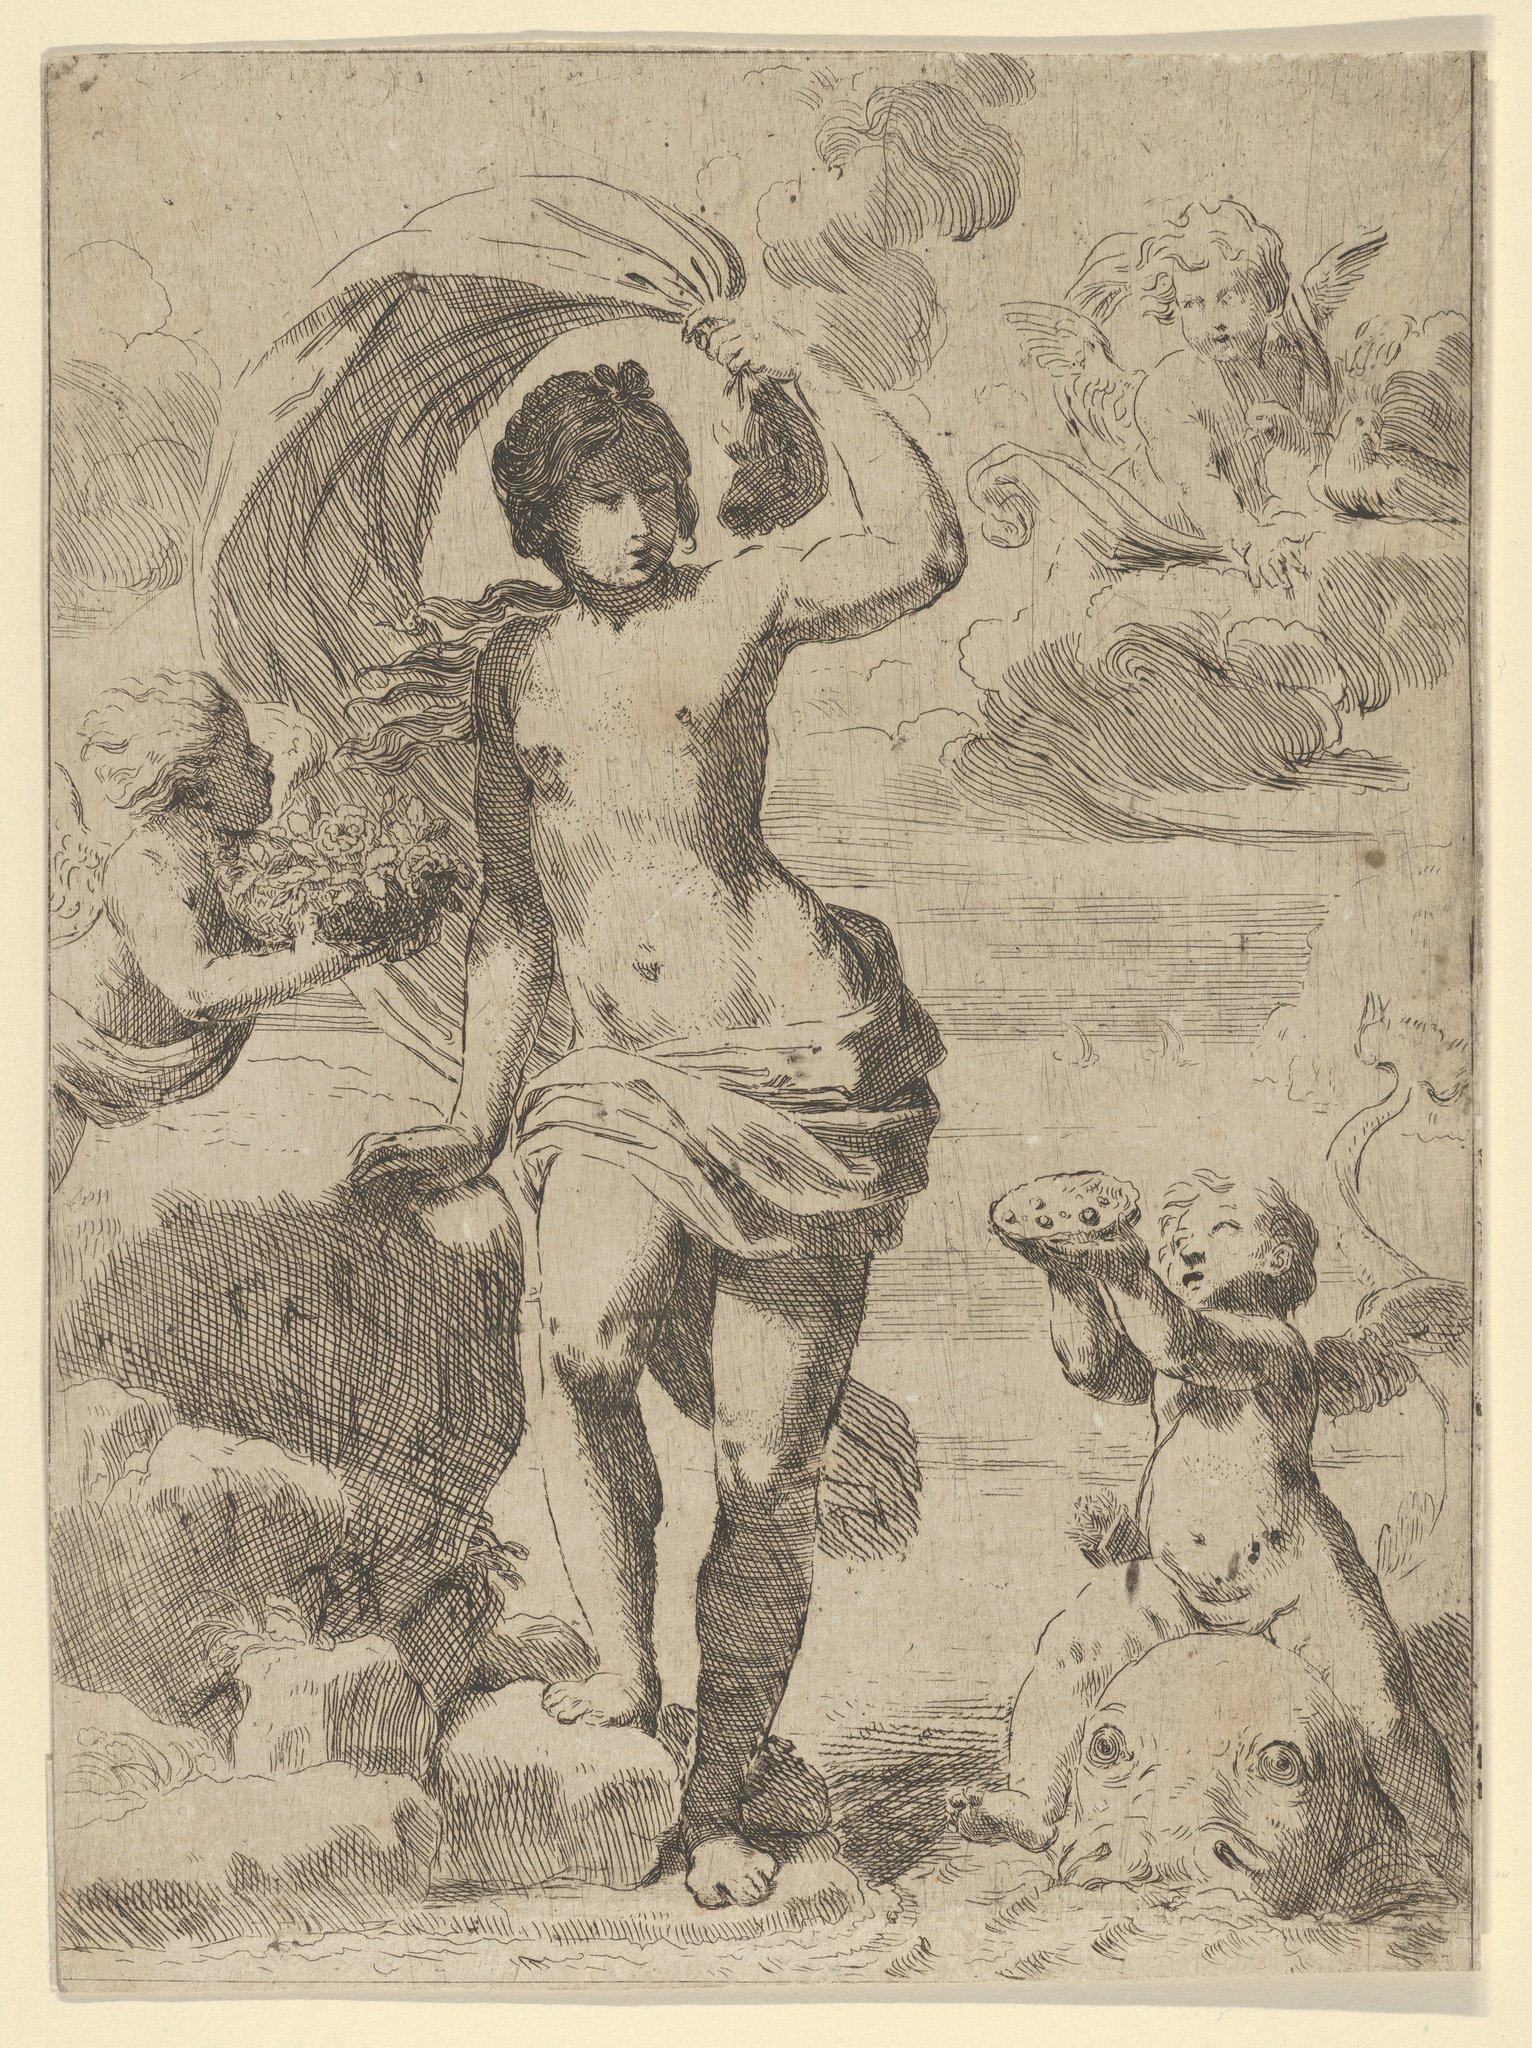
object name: print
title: Venus stepping out of the sea, holding a billowing drapery in her left hand, Cupid at right offering pearls while riding a dolphin and a putto at left offering flowers, another in the clouds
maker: Anonymous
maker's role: artist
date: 1600-1640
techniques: etching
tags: cupid,venus,dolphins